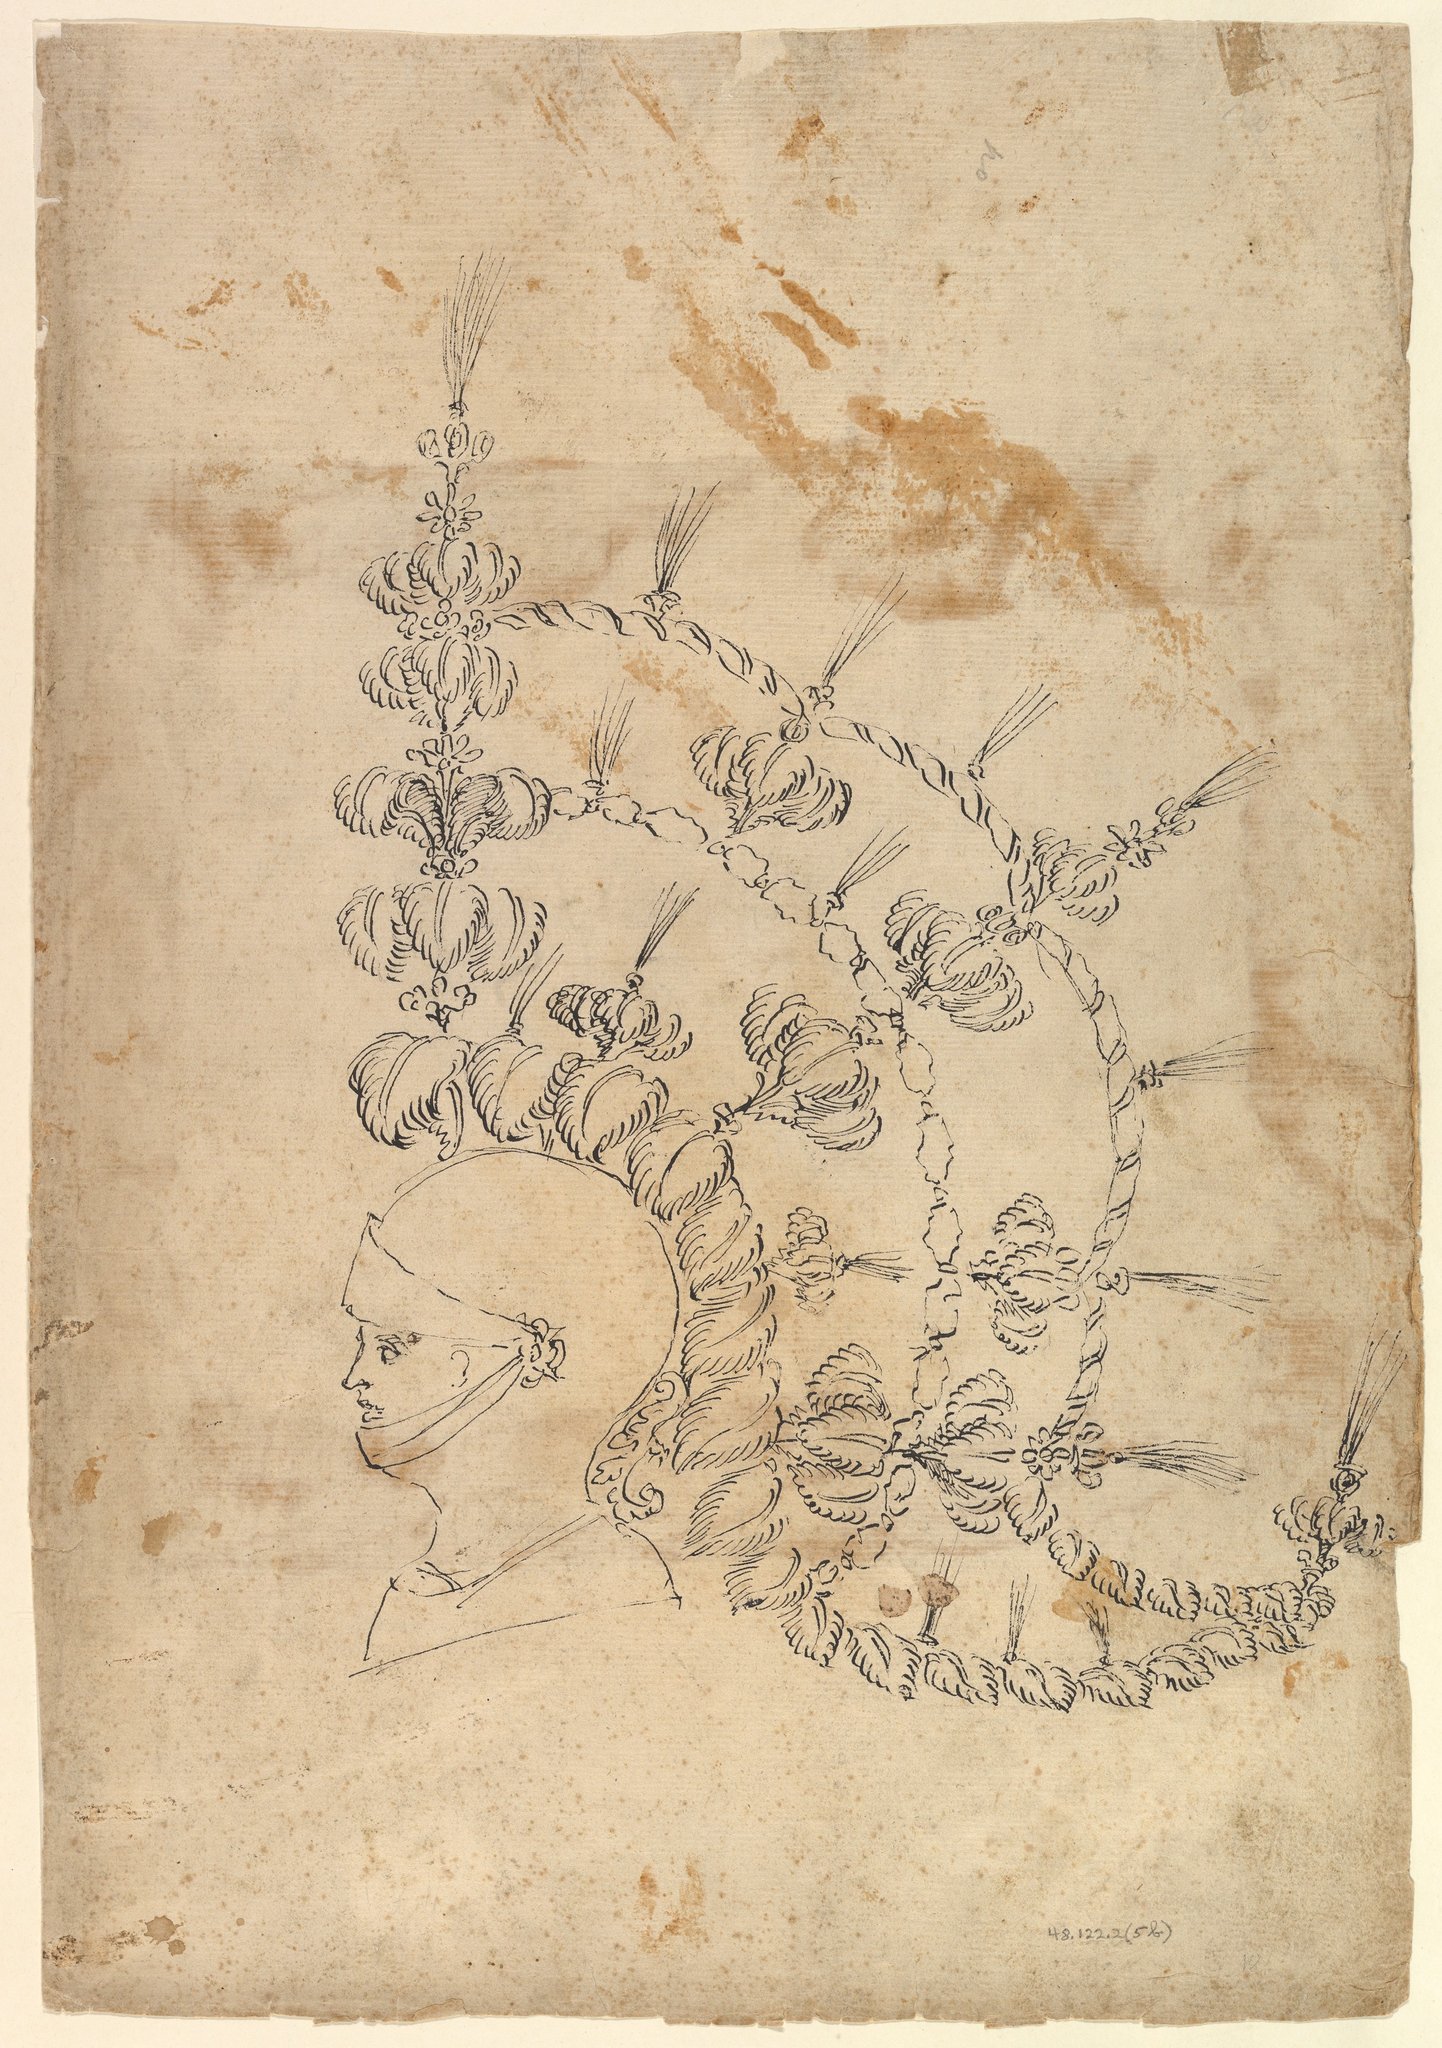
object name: collection ornament architecture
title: Design for an Armor Helmet with Tournament Headdress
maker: baccio del bianco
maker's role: artist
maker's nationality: italian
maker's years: 1604-1656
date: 1620-1656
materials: ink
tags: helmets,heads